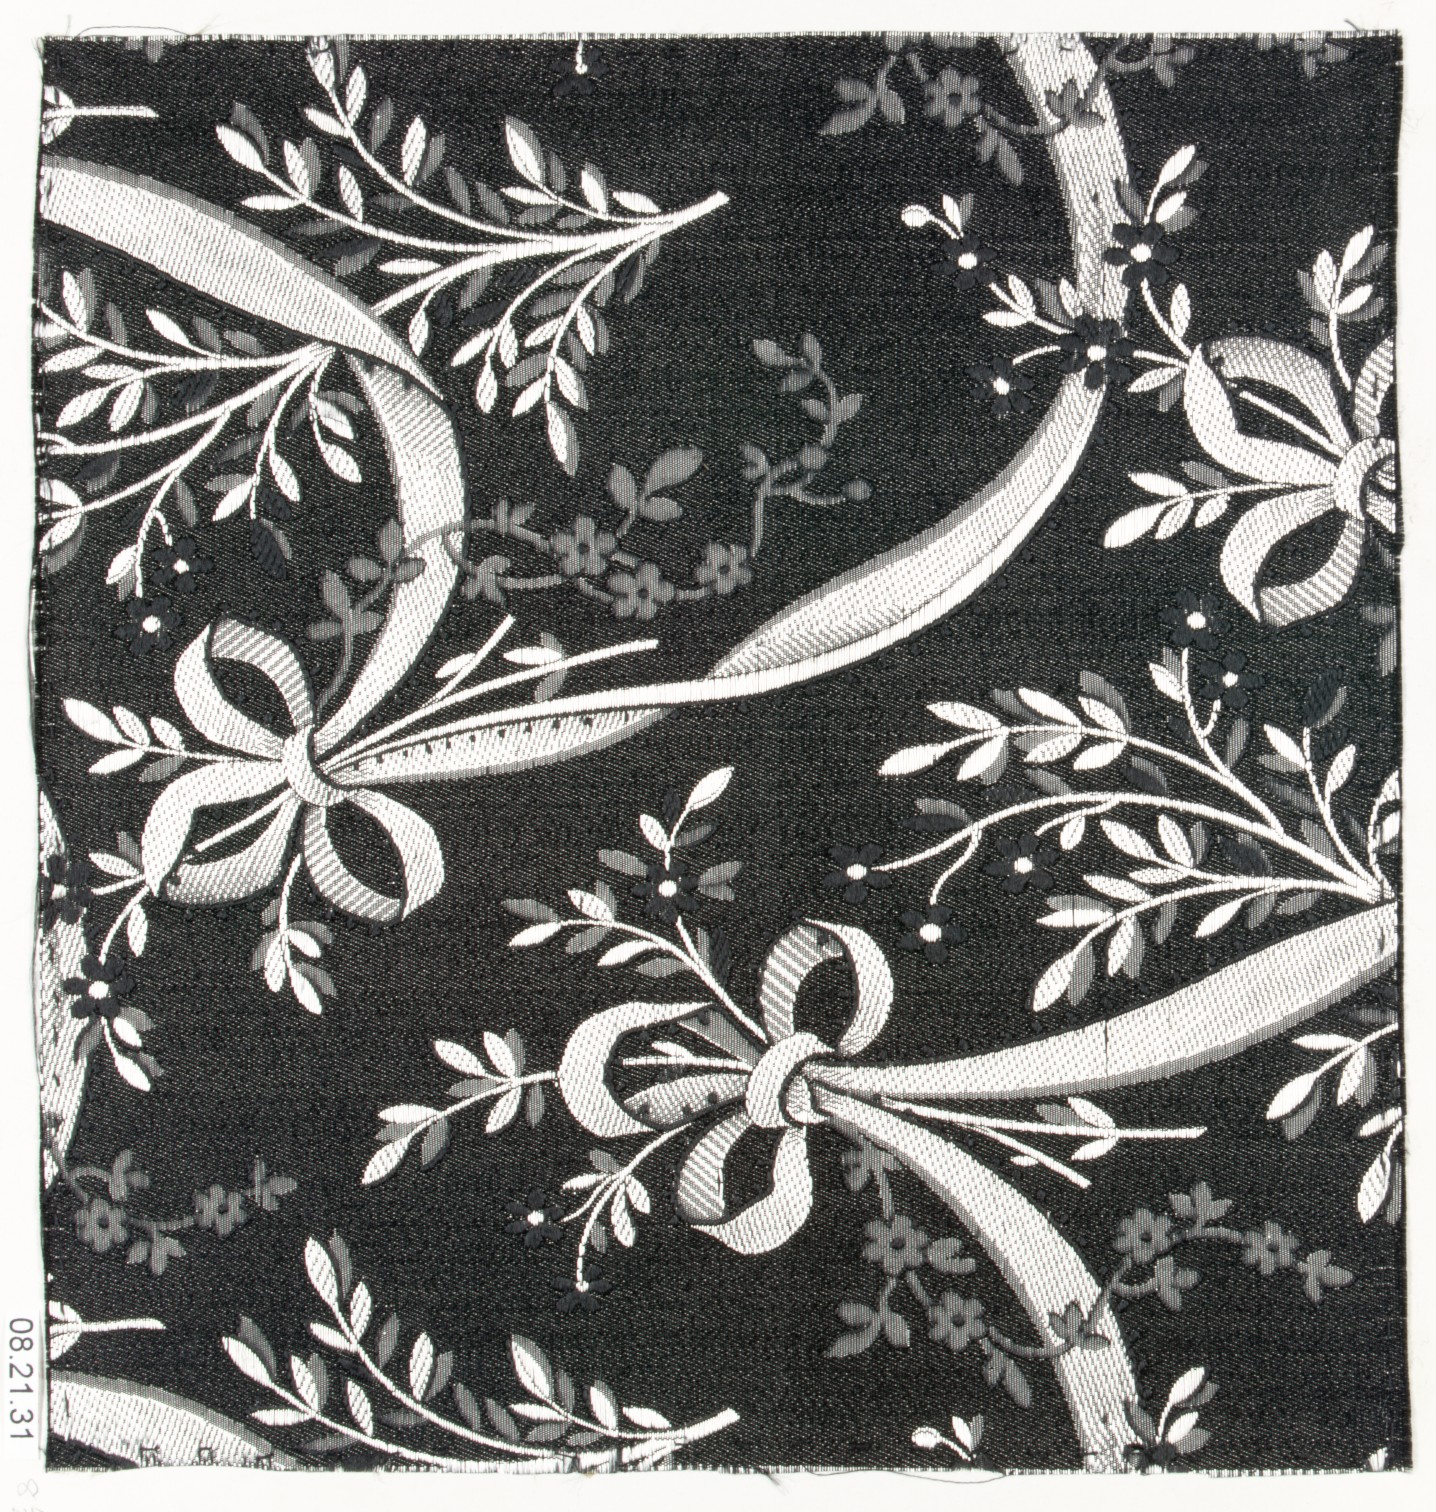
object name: textile sample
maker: Anonymous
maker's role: designer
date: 1900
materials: silk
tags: plants